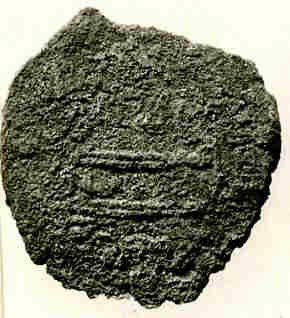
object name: coin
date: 767-800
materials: copper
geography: iran